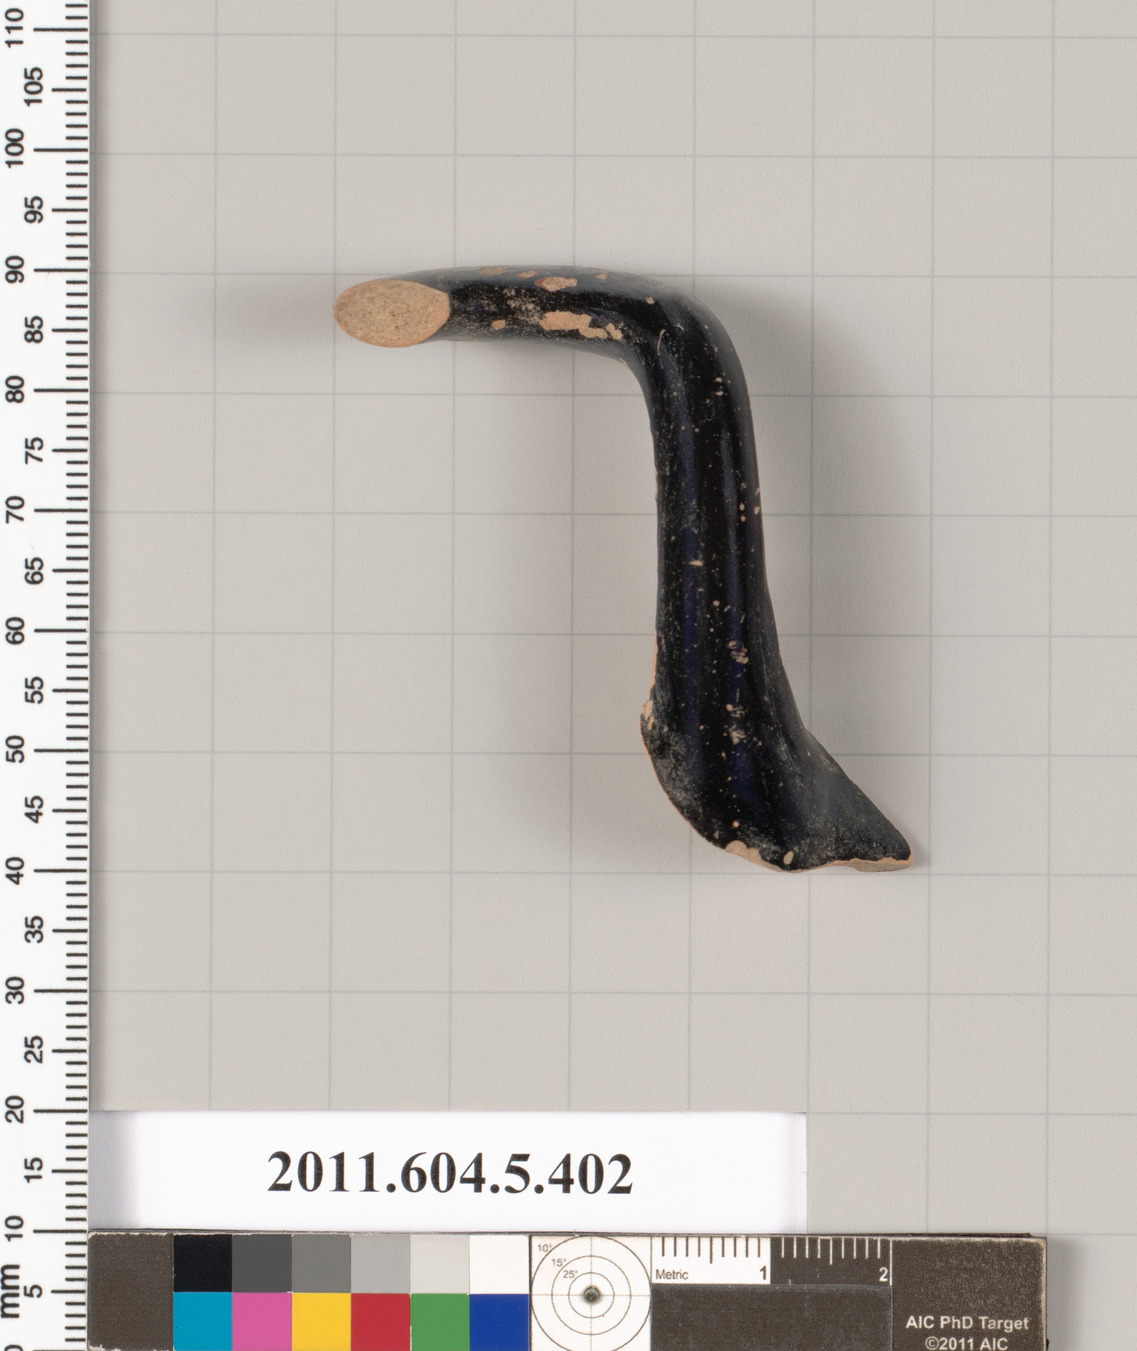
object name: kylix fragment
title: Terracotta fragment of a kylix (drinking cup)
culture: greek, attic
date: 600-401 BCE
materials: terracotta